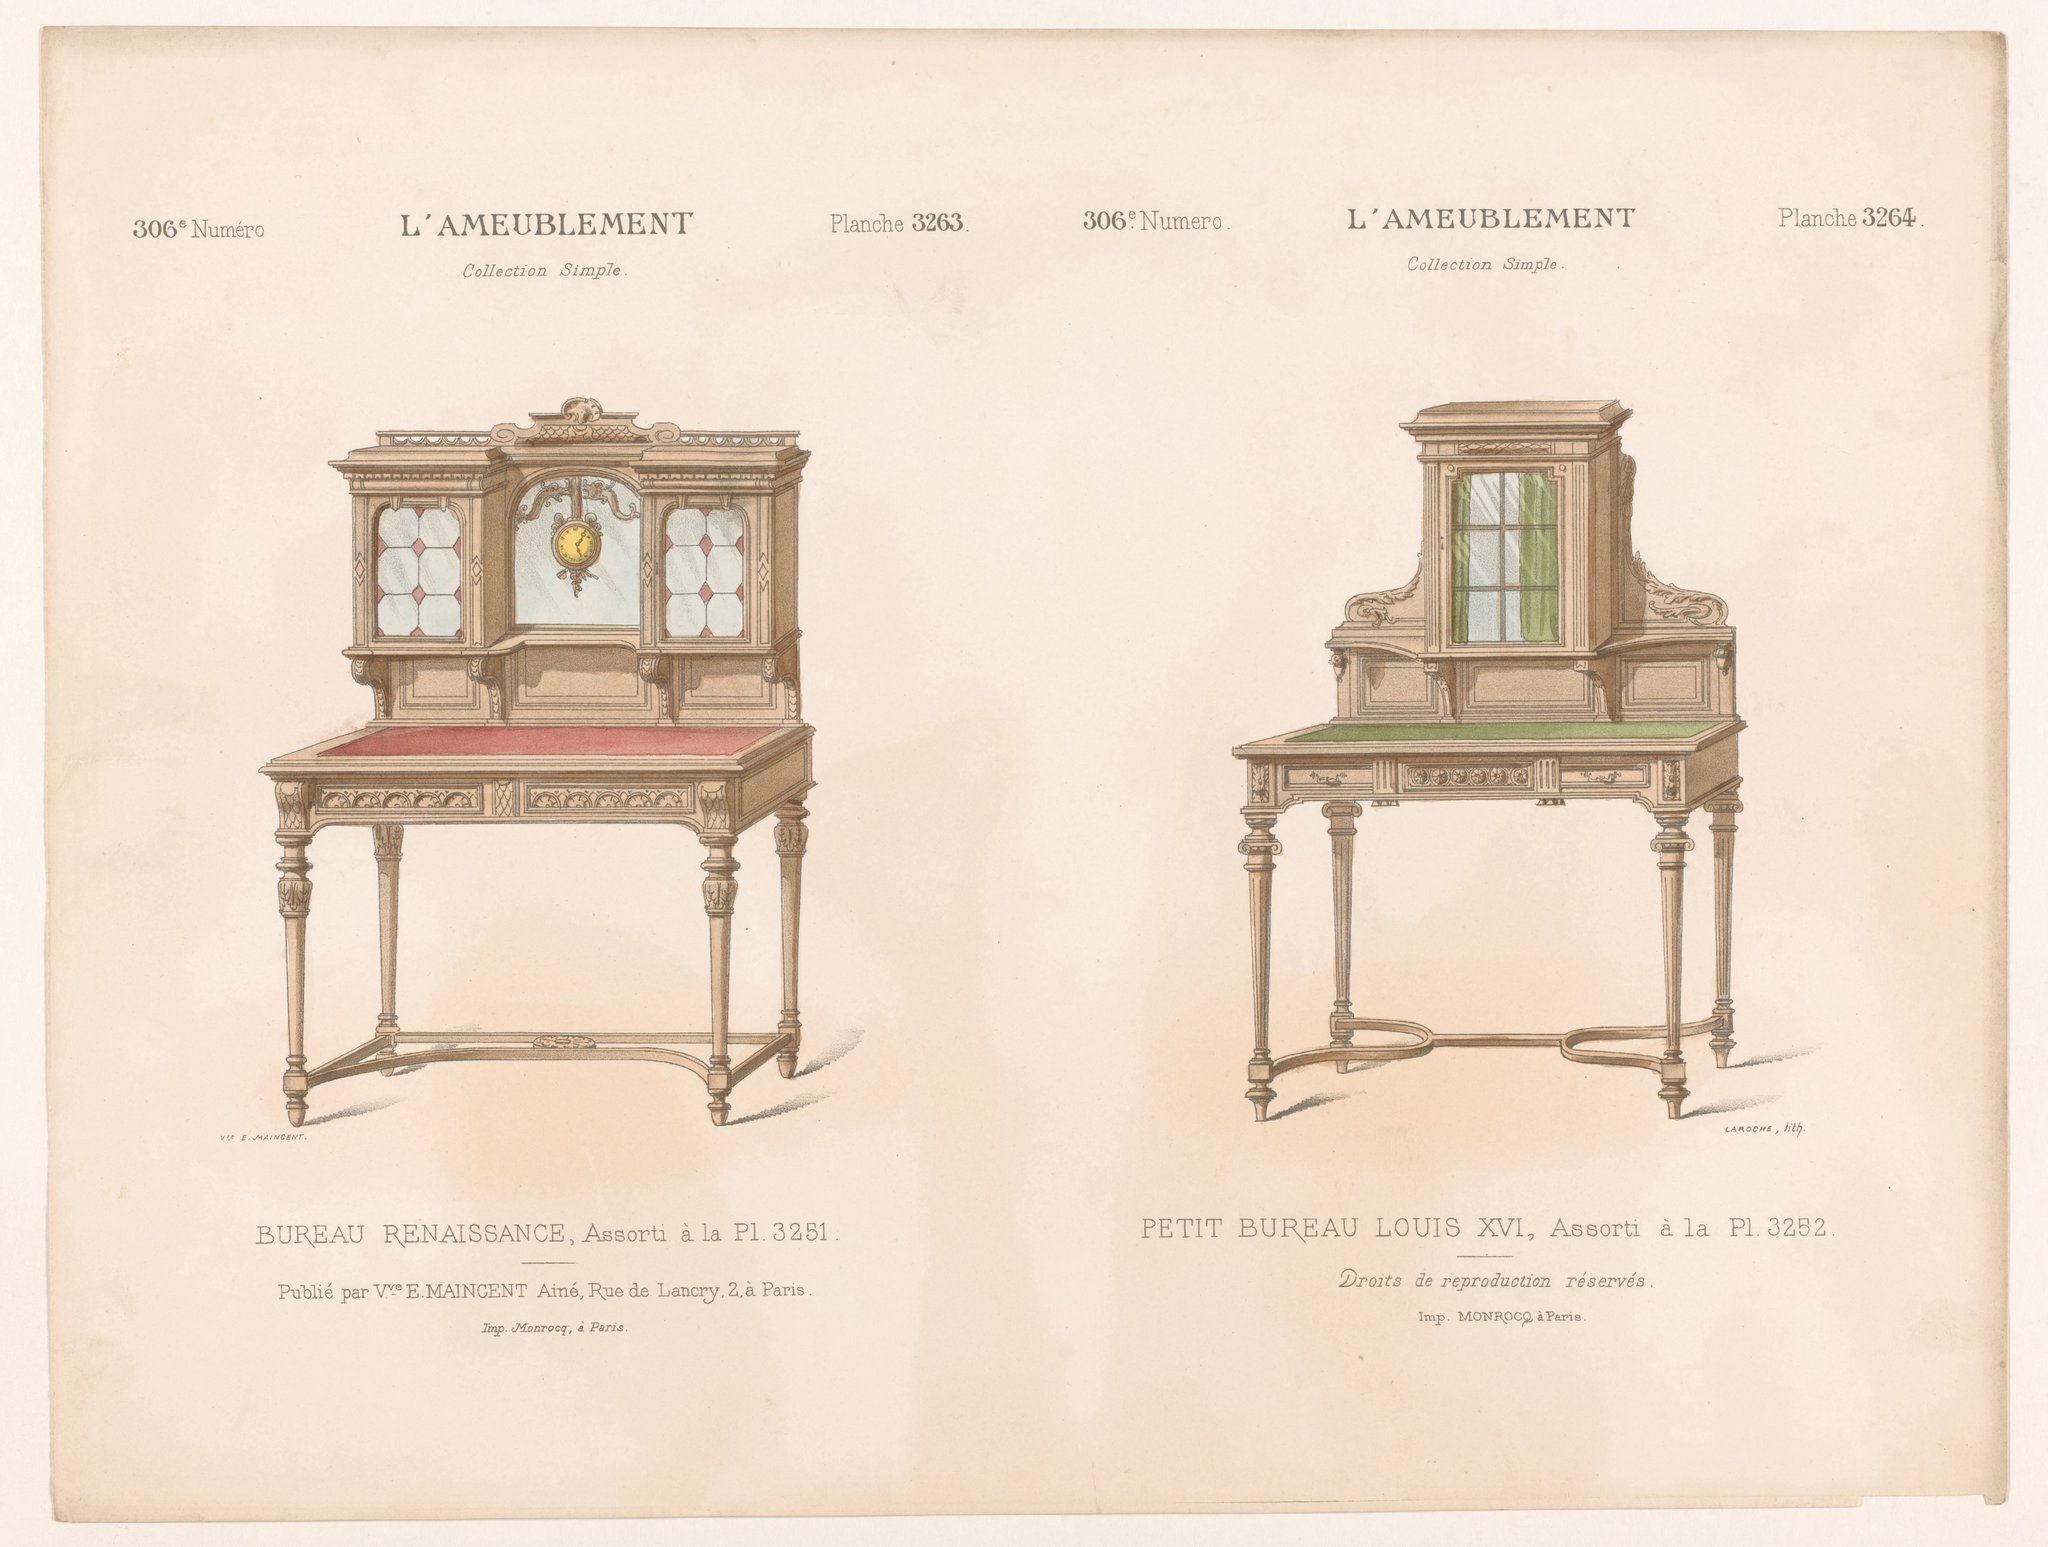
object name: print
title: L'ameublement / Collection simple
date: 1895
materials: paper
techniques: hand coloring, lithograph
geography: paris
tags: writing-table, writing-desk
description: Twee bureaus in de stijlen van de renaissance en Lodewijk XVI. Prent uit 306e nummer (livraison).